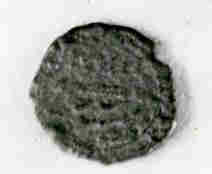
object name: coin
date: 701-900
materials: copper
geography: iran